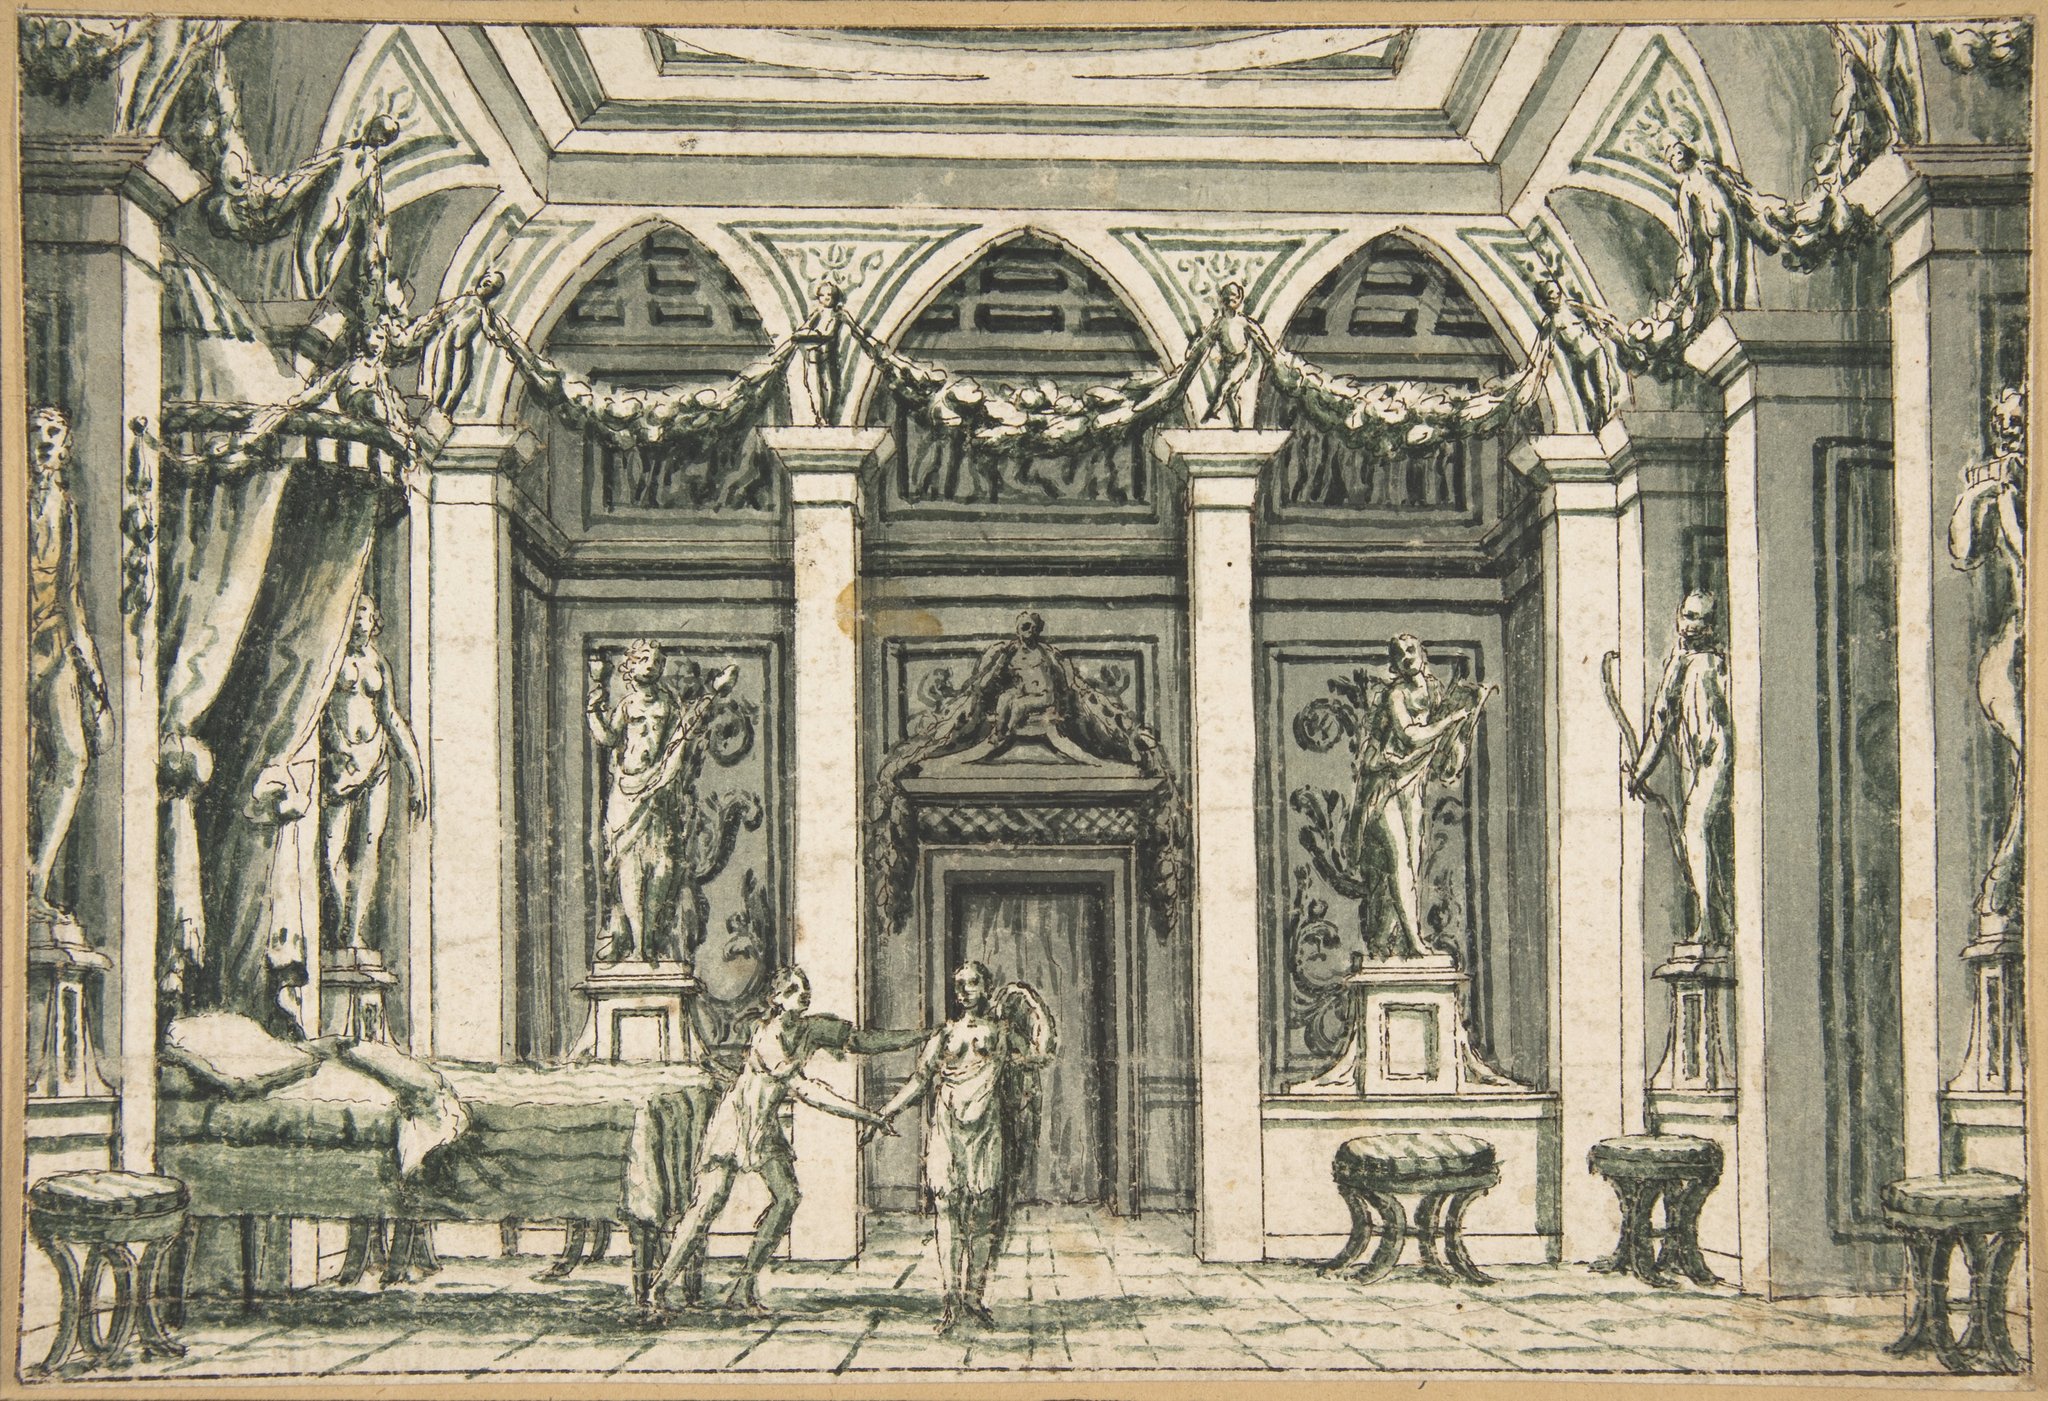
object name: drawing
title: Theater Design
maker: anonymous, french, 18th century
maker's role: artist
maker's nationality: french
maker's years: 1700-1800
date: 1701-1800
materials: ink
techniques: heightening, pen, wash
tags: theatre,interiors